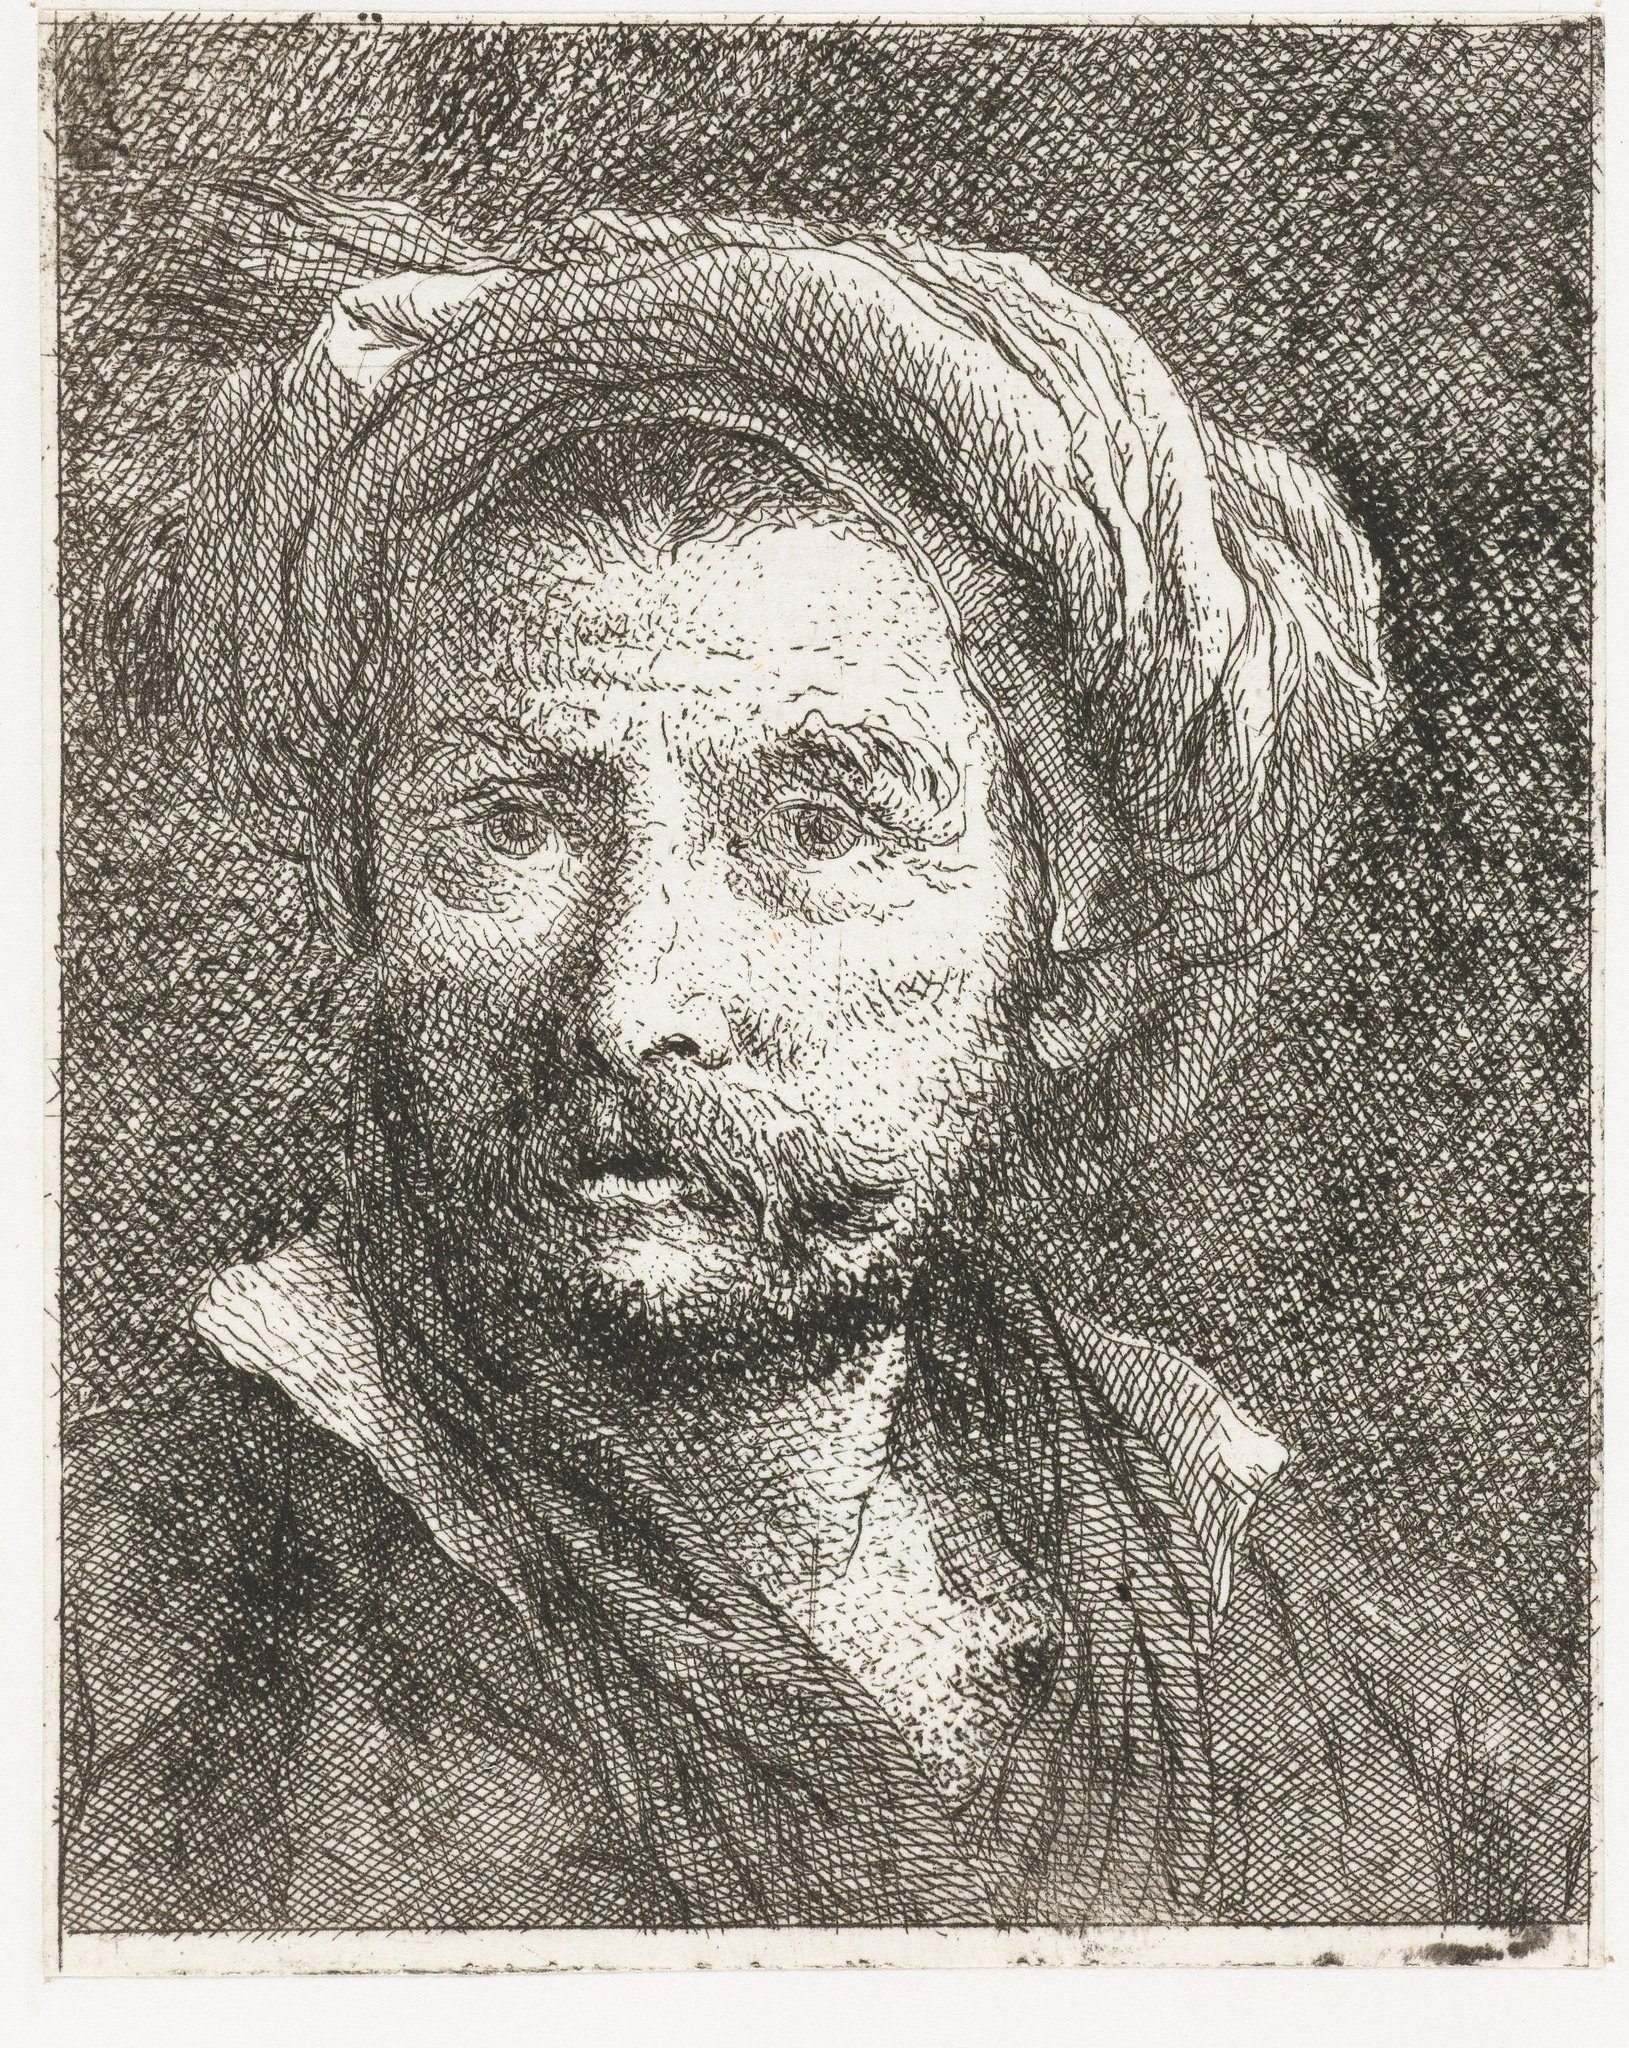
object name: print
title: Man met snor en tulband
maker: giovanni domenico tiepolo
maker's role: draughtsman, print maker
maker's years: 1727-1804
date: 1771-1774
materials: paper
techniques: etching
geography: venice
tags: head-gear: turban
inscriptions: collector's mark: Lugt 2228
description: Prent uit serie Verzameling hoofden (Raccolta di teste). Giovanni Domenico Tiepolo vervaardigde in de winter van 1757-1758 en in de periode van 1771-1774 deze hoofden naar schilderijen en tekeningen van Giovanni Battista Tiepolo. De eerste uitgave verscheen in 1774 in twee delen met elk dertig prenten. Deze prent werd in de tweede staat met serienummer 3 opgenomen in deel 2.